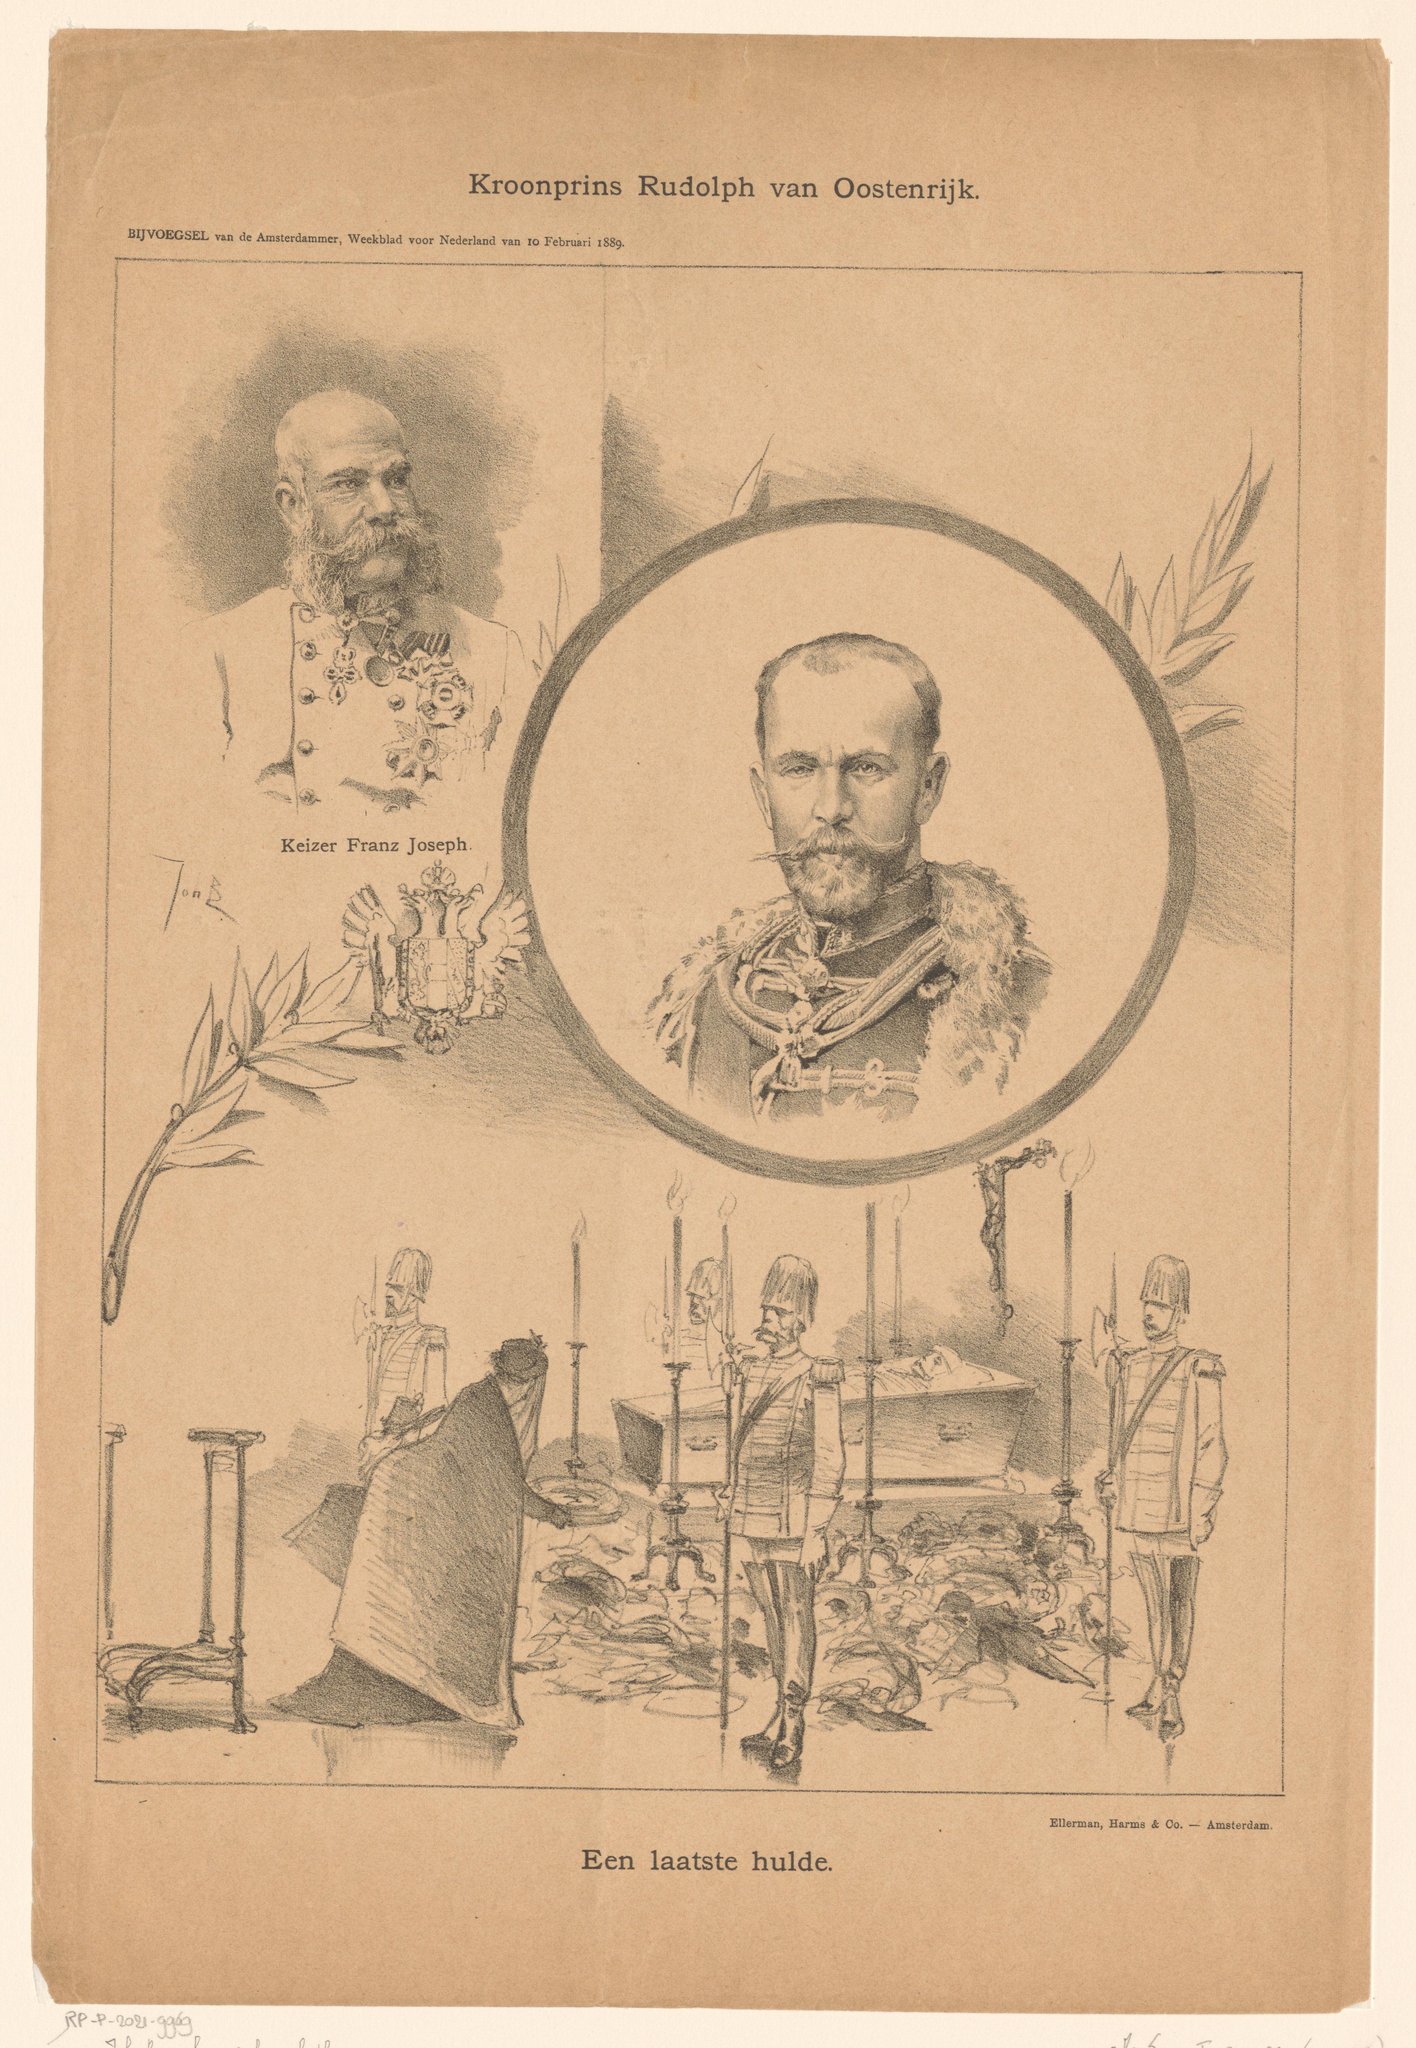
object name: print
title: Portretten van Rudolf van Oostenrijk en Frans Jozef I Karel, keizer van Oostenrijk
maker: johan braakensiek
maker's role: draughtsman, print maker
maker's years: 1858-1940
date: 1889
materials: paper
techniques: lithograph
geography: amsterdam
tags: historical persons, emperor, funerary ceremonial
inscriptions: collector's mark: Lugt 2228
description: Deze prent werd uitgegeven als bijvoegsel bij De Amsterdammer op 2 februari 1889.